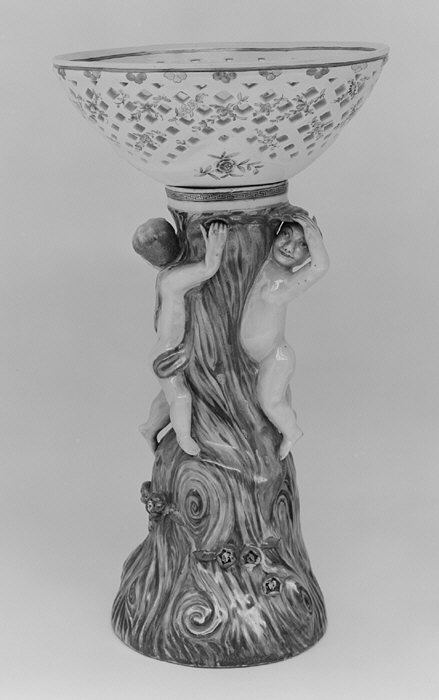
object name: fruit basket and stand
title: Fruit basket and stand (one of a pair)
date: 1790-1800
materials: hard paste porcelain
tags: putti